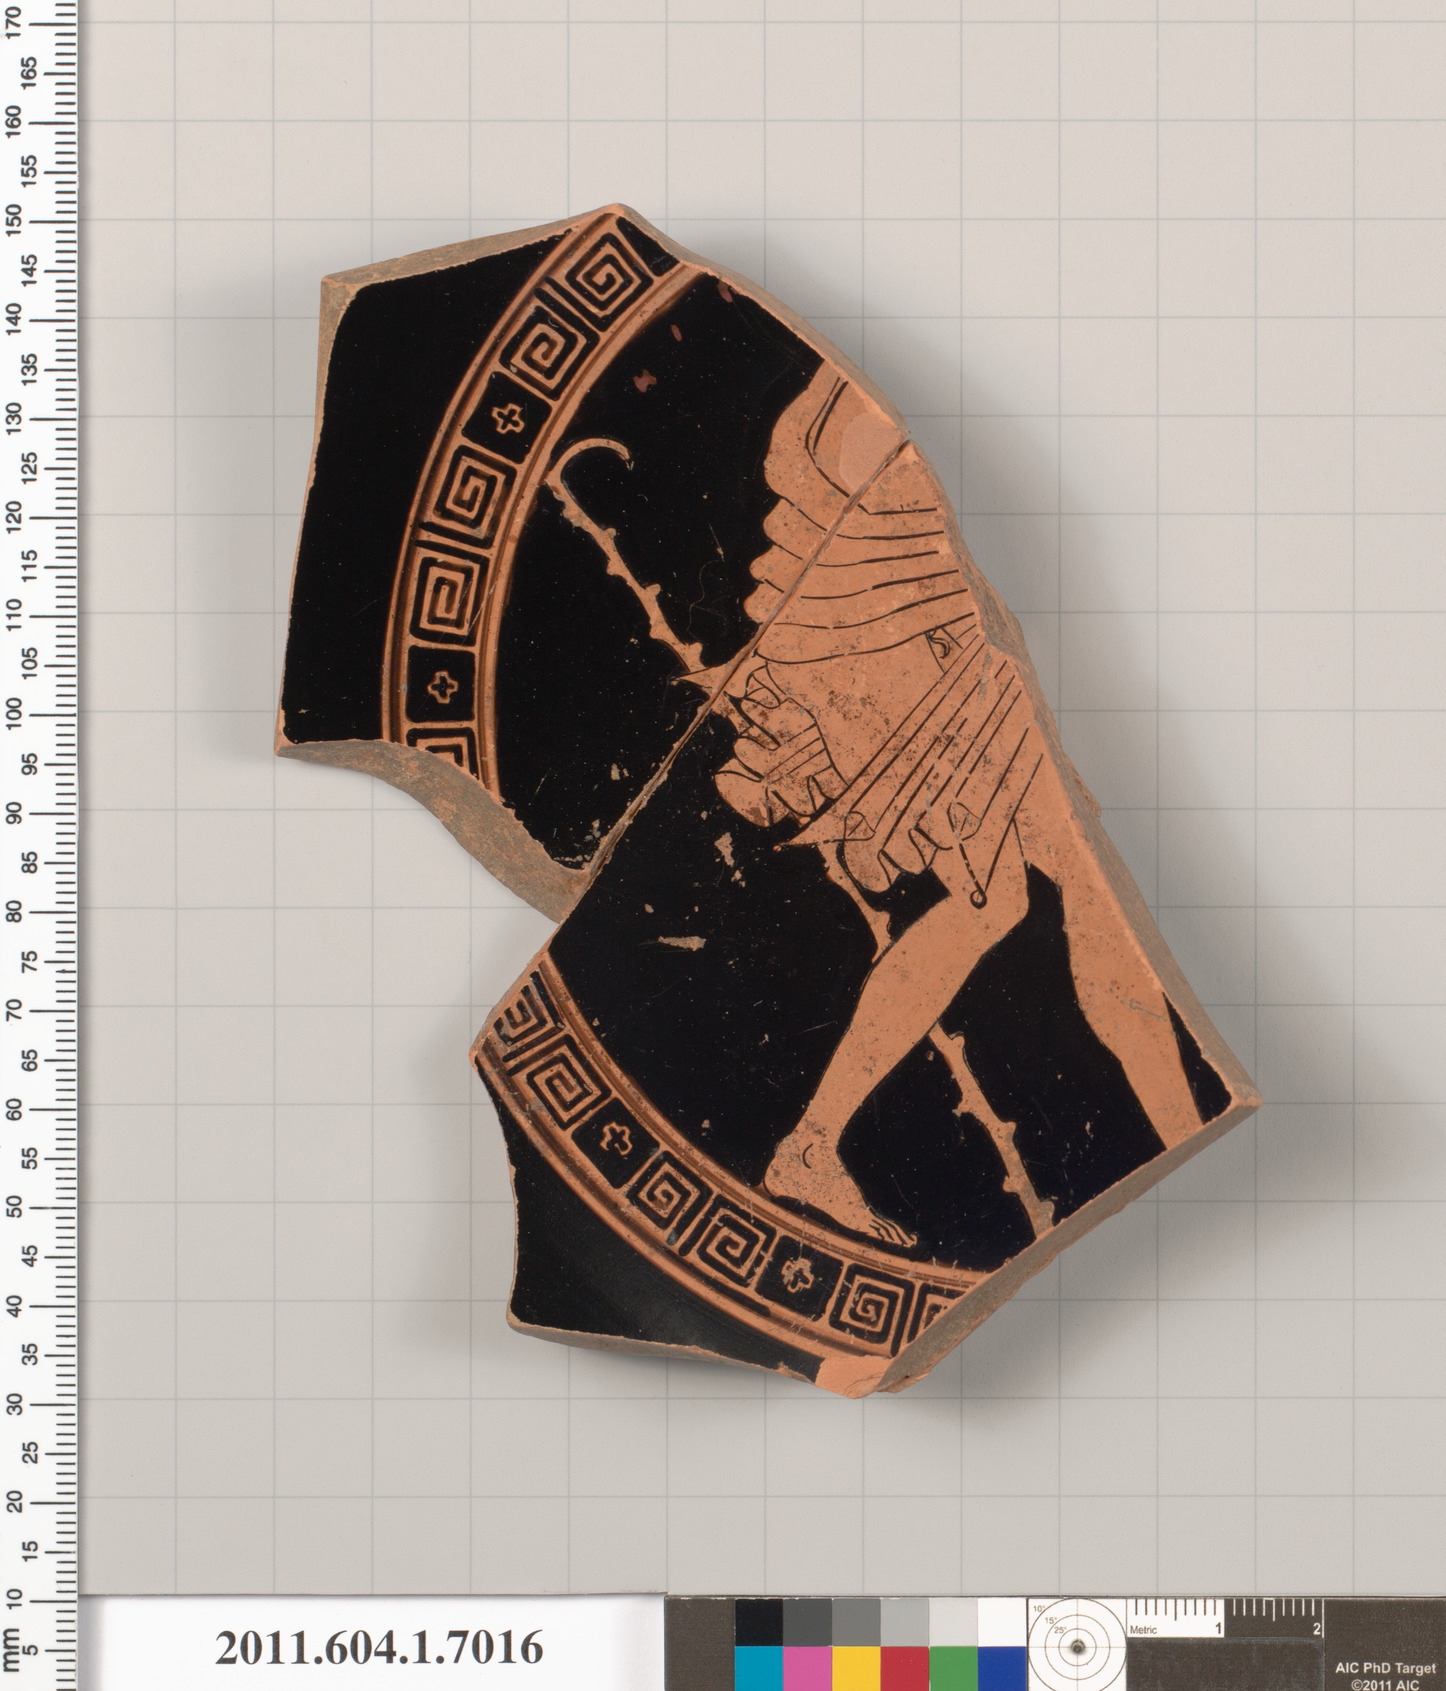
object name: kylix fragment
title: Terracotta fragment of a kylix (drinking cup)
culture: greek, attic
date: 500-480 BCE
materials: terracotta